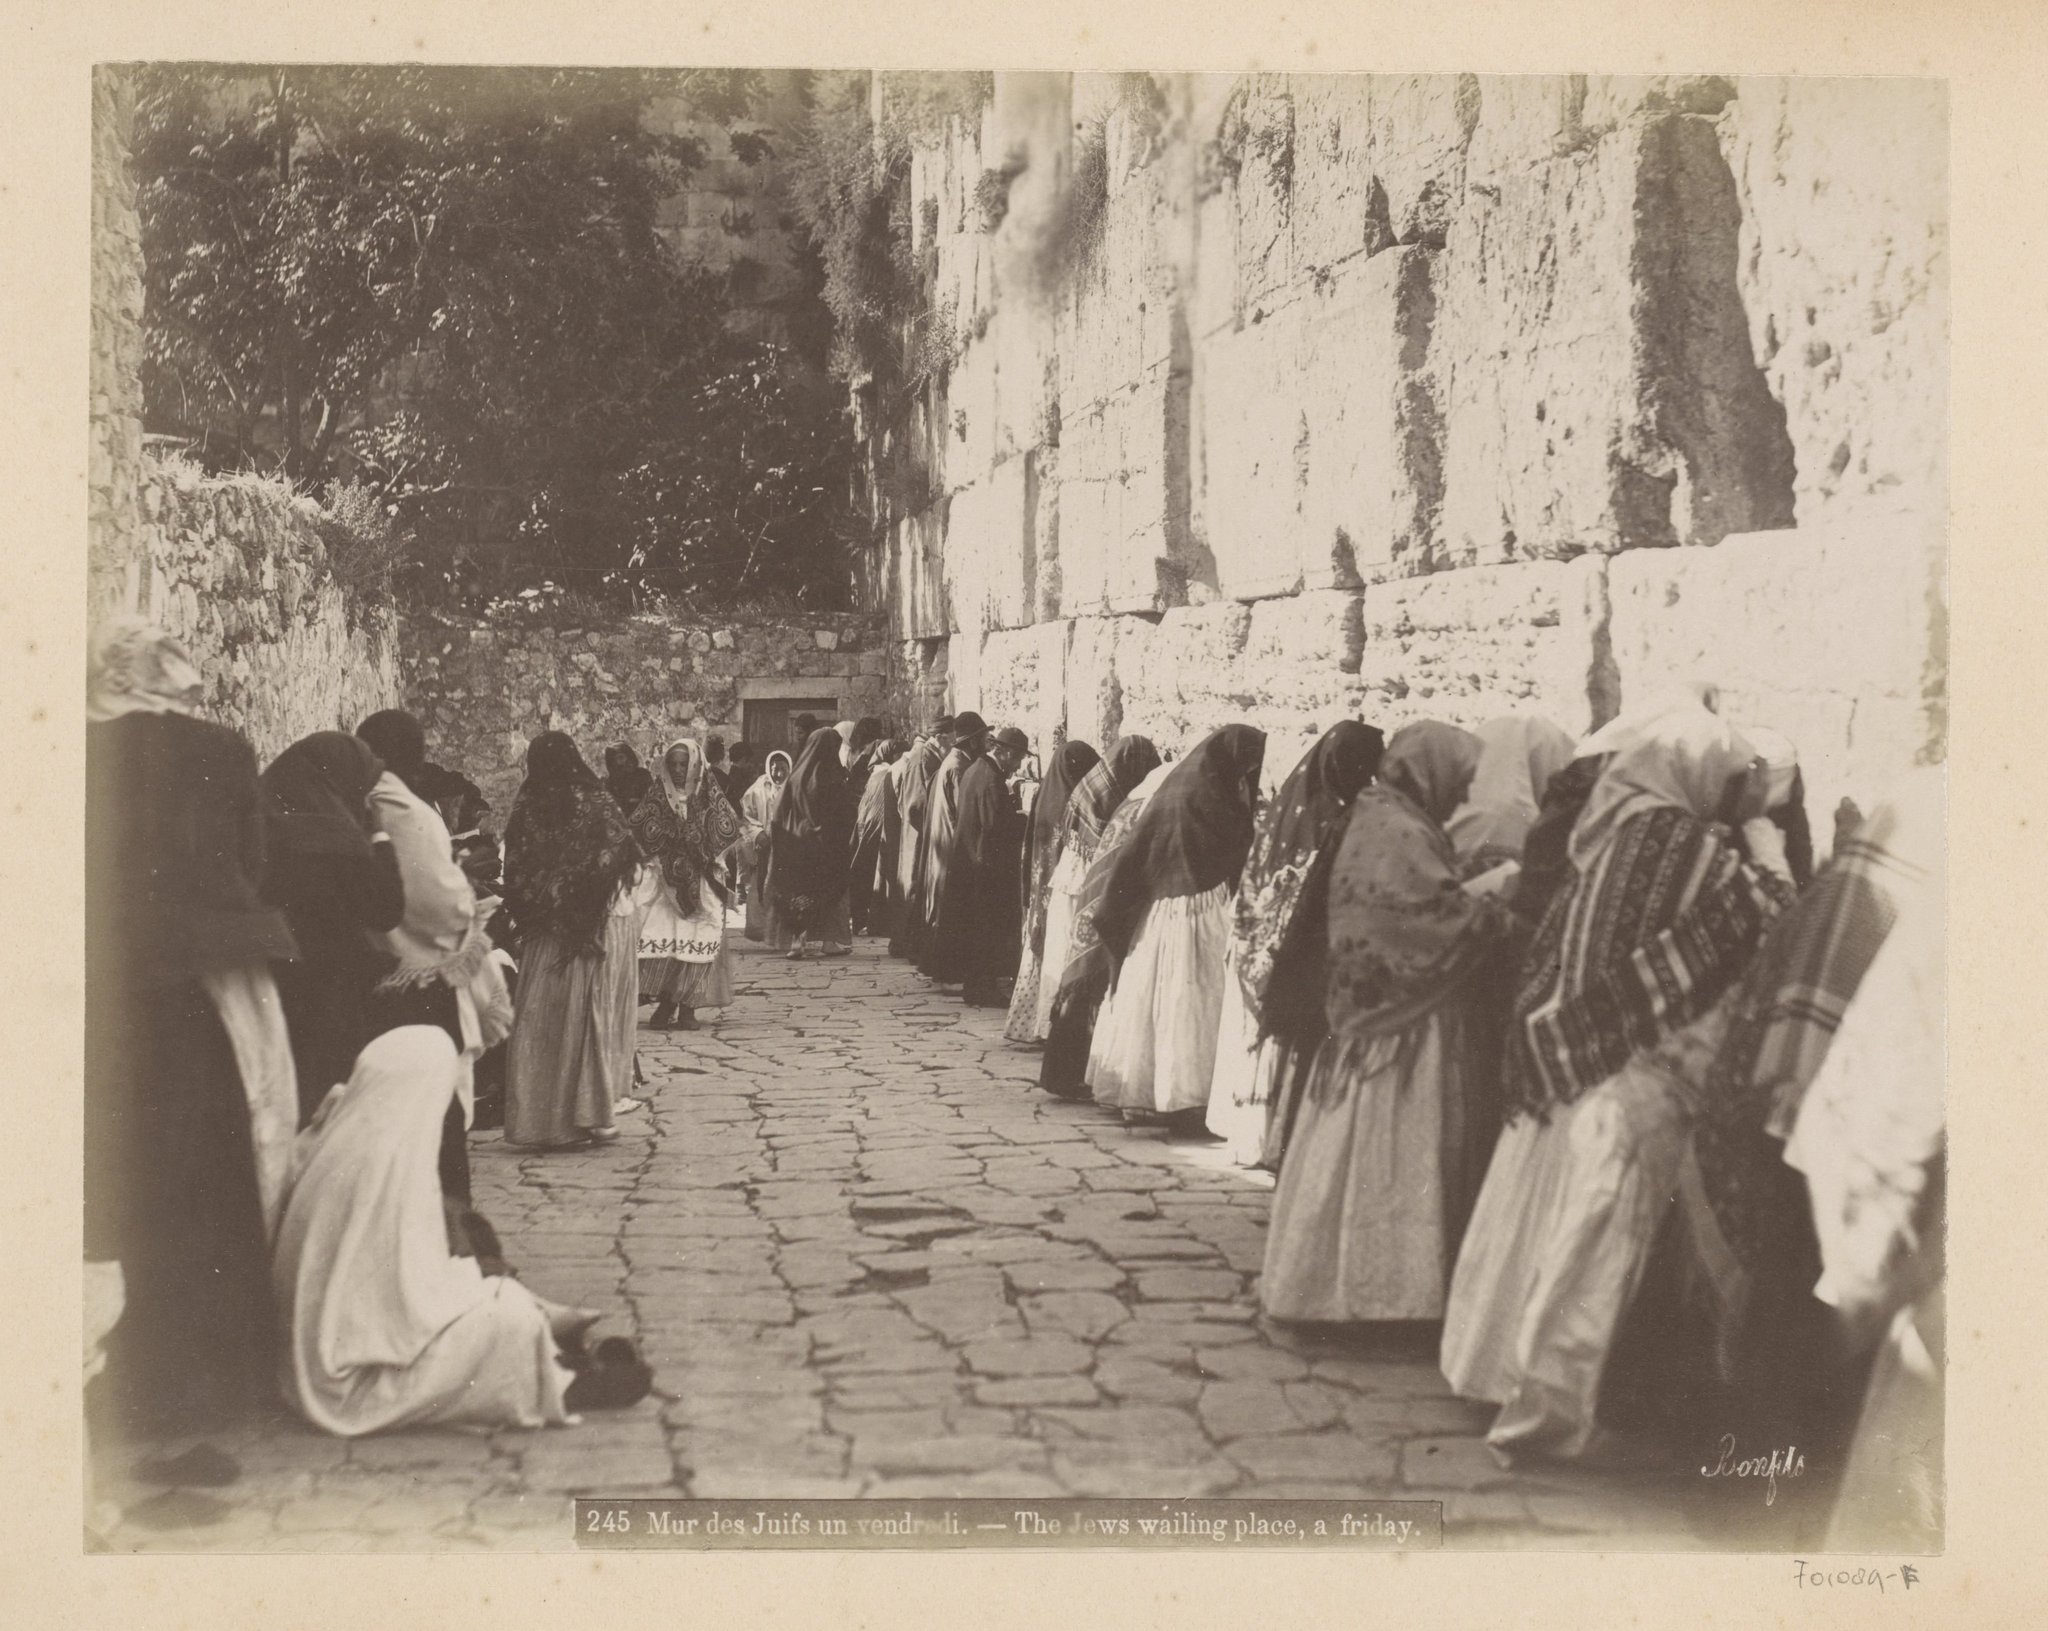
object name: photograph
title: Mur des Juifs un vendredi. - The Jews wailing place, a friday.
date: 1867-1895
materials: cardboard, paper, photographic support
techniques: albumen print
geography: jerusalem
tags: prayer, praying ~ jewish religion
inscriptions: negative number: ‘245’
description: Onderdeel van Reisalbum met foto's van Jeruzalem en andere bijbelse plaatsen.